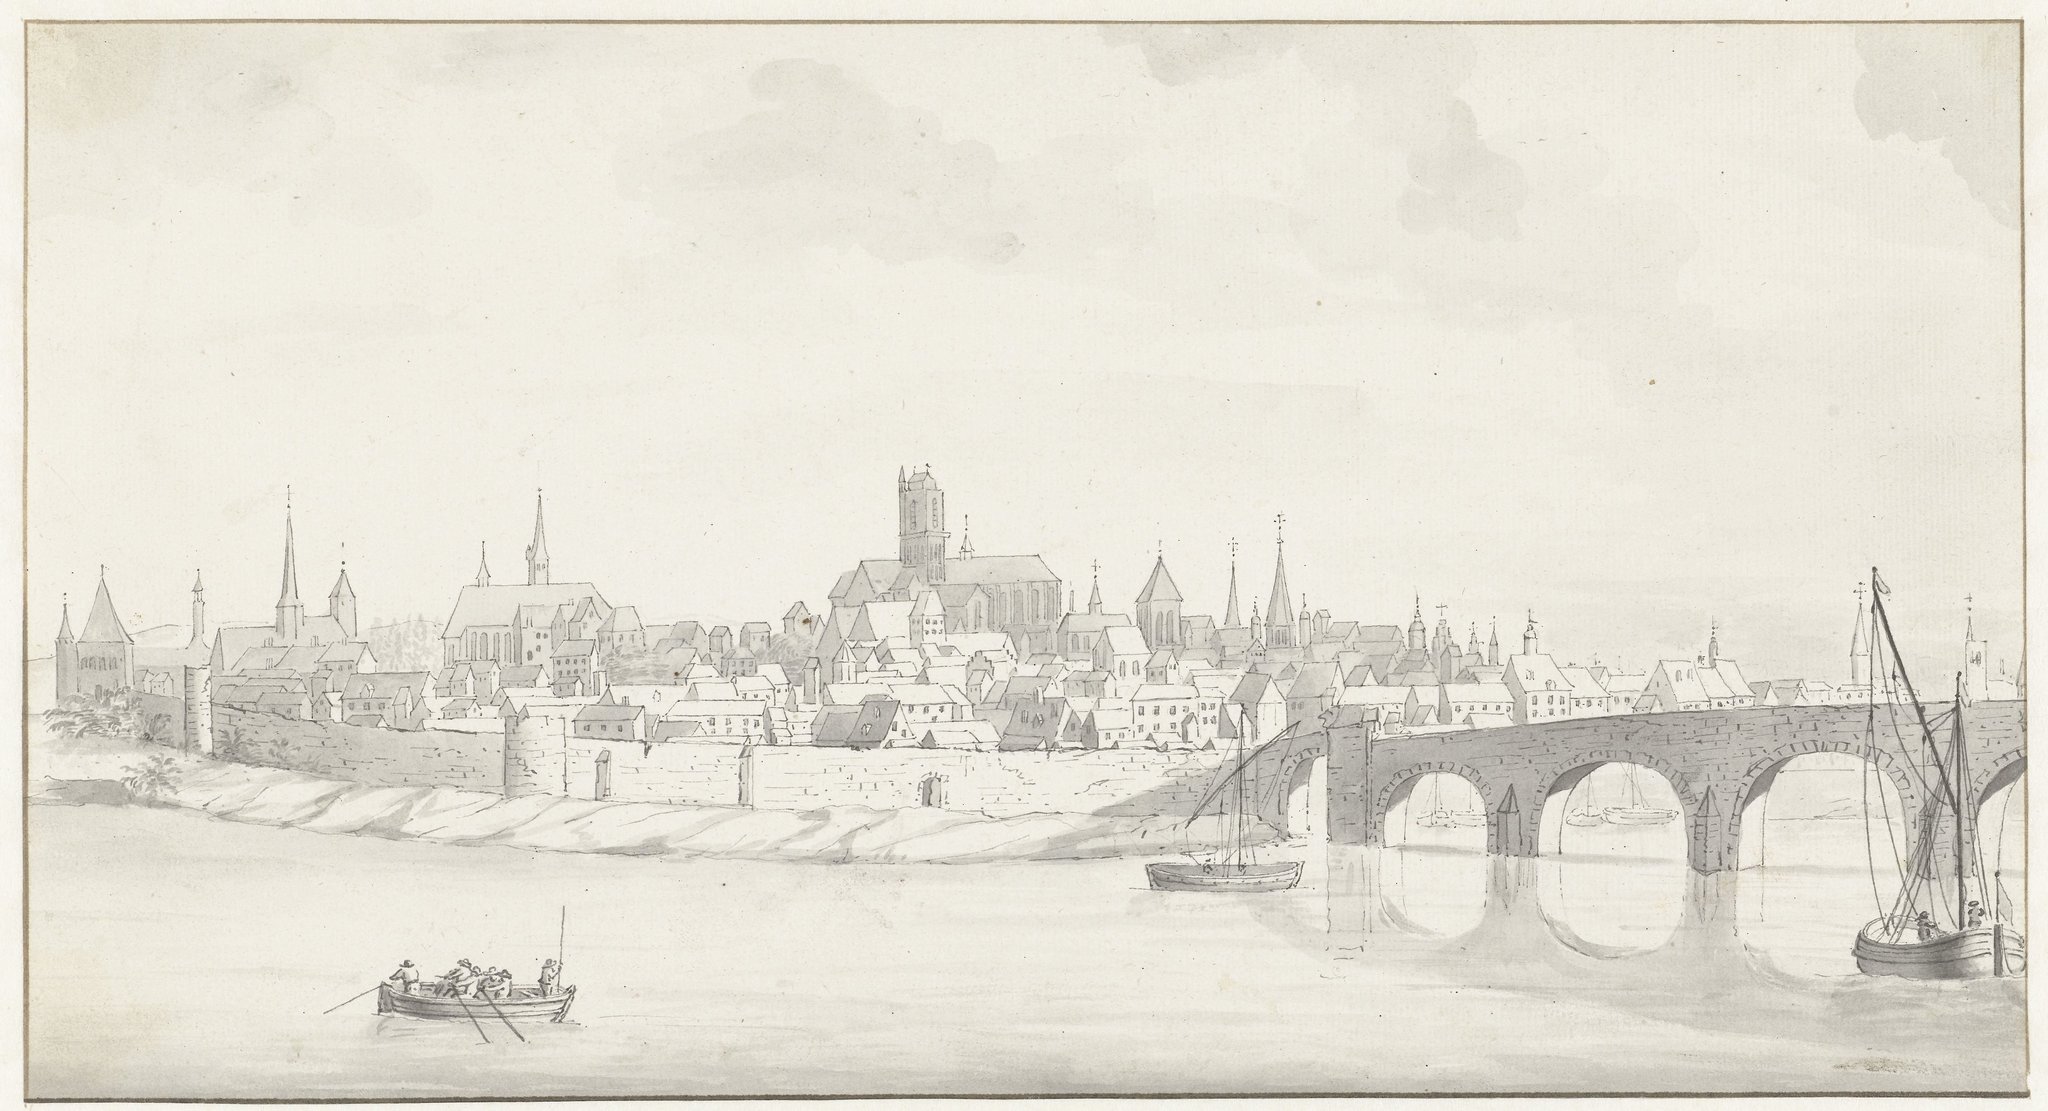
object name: drawing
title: Gezicht op de stad Nevers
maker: jan van call (i)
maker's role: draughtsman, print maker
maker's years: 1656-1706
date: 1666-1706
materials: ink, paper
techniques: brush, pen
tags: nevers